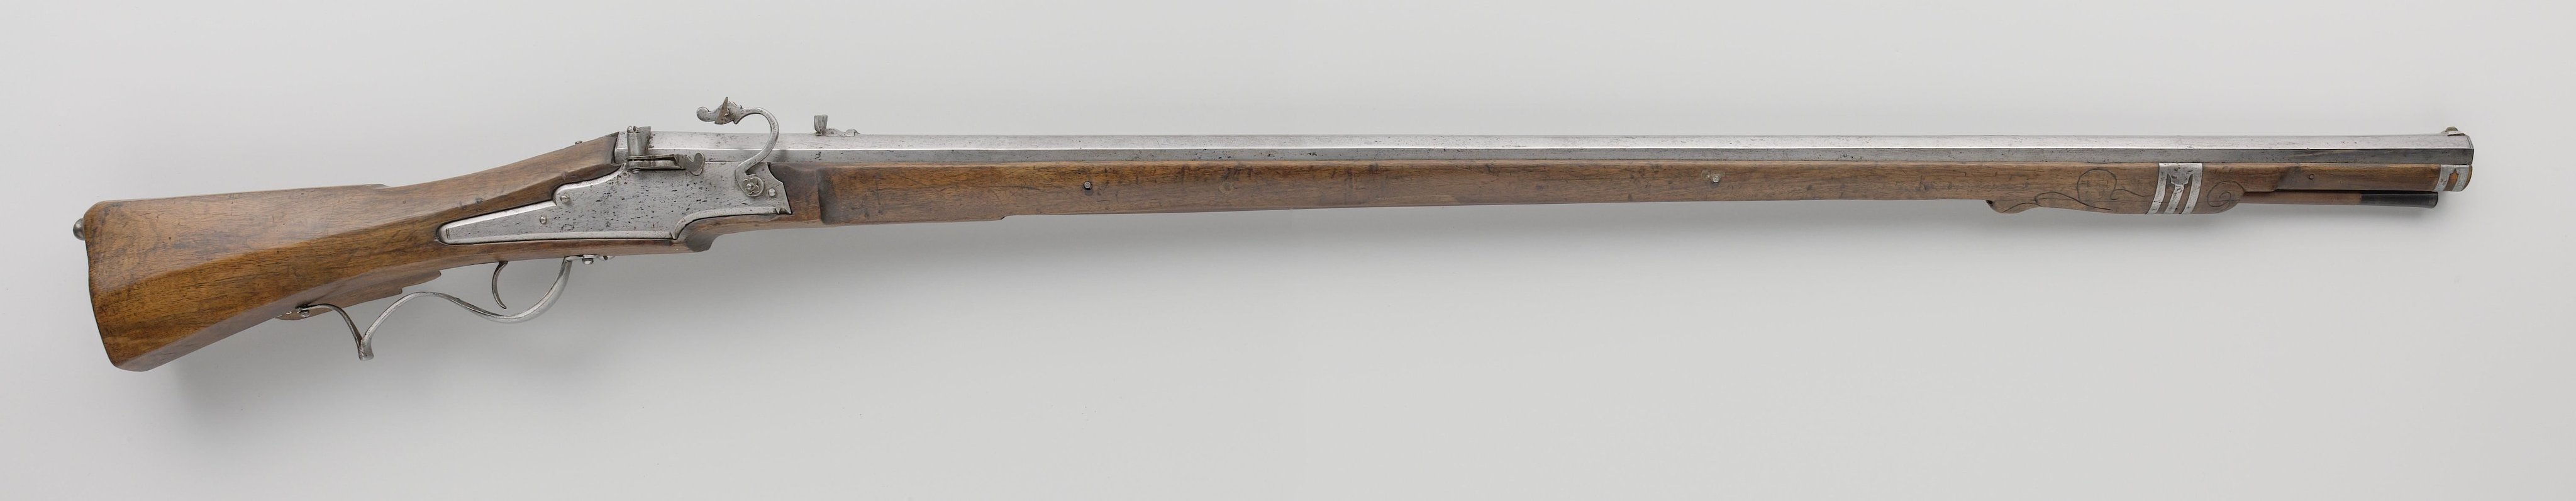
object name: matchlock rifle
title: Lontslotmusket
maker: Anonymous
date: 1638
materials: iron, wood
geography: netherlands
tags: low countries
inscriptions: date: ‘1638’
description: Musket, probably made in the Netherlands, 1638.